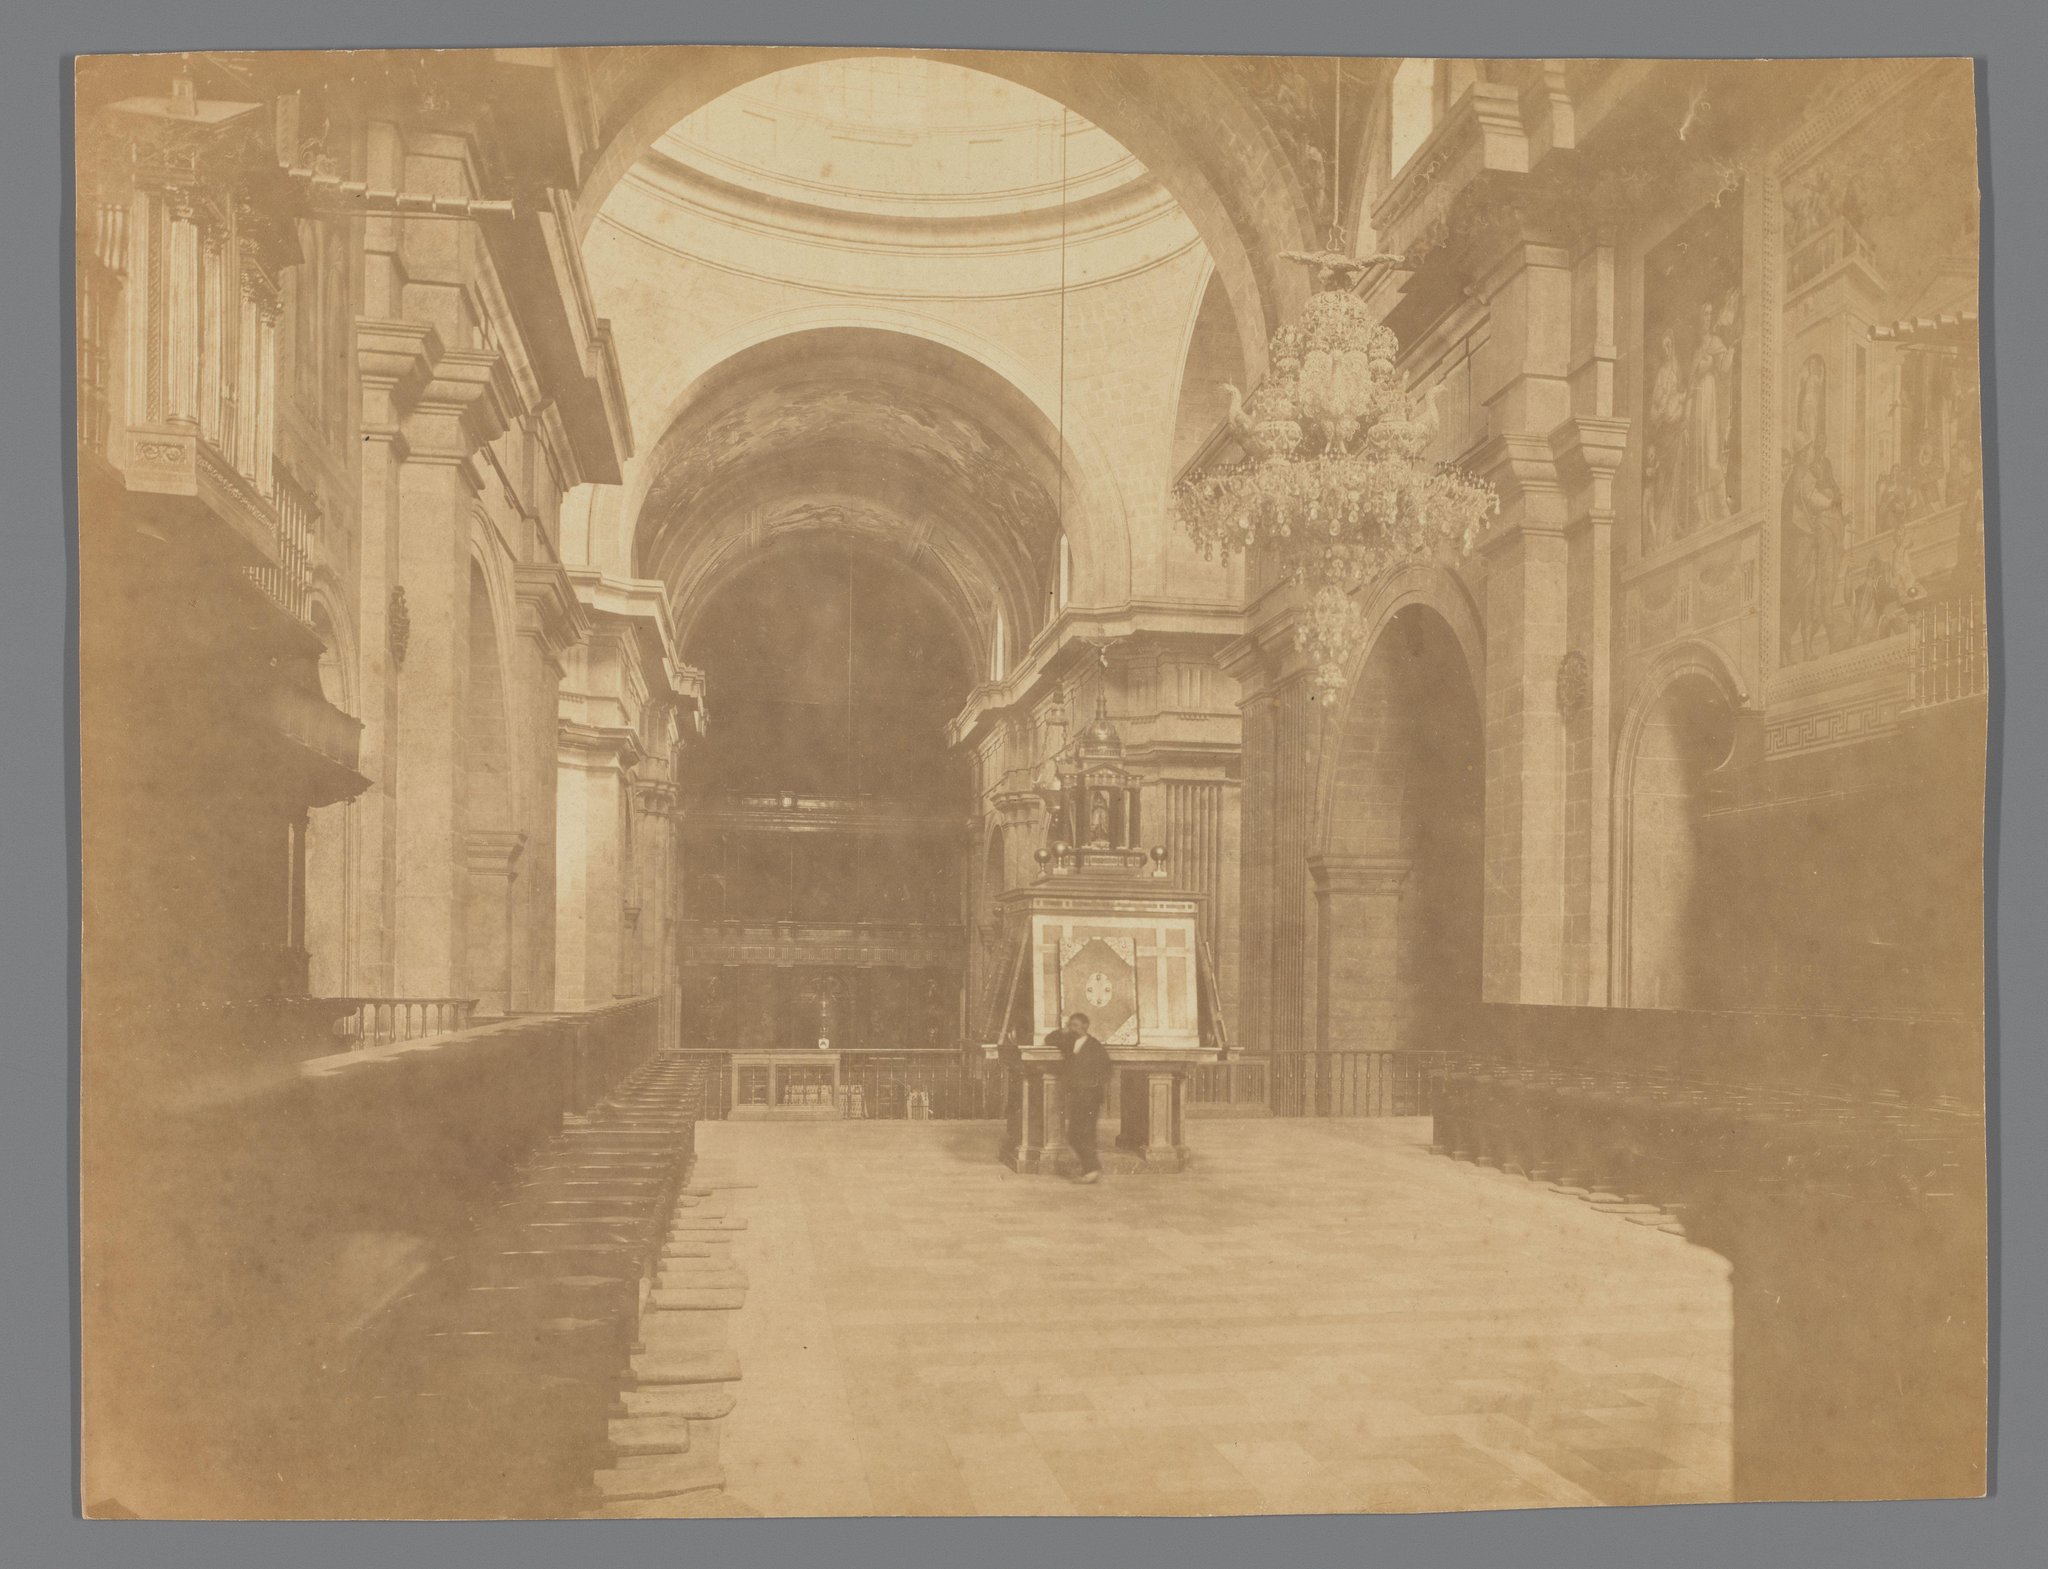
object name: photograph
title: Vista del Coso de la iglesia del Monasterio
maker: Anonymous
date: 1850-1899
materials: cardboard, pencil, photographic support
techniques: albumen print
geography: spain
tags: spain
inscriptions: stamp: ‘UNIVERSITEIT VAN AMSTERDAM / KUNST / HISTORISCH / INSTITUUT’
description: Foto uit de studiecollectie van het Kunsthistorisch Instituut van de Universiteit van Amsterdam, met verso fragmenten van potloodtekeningen.